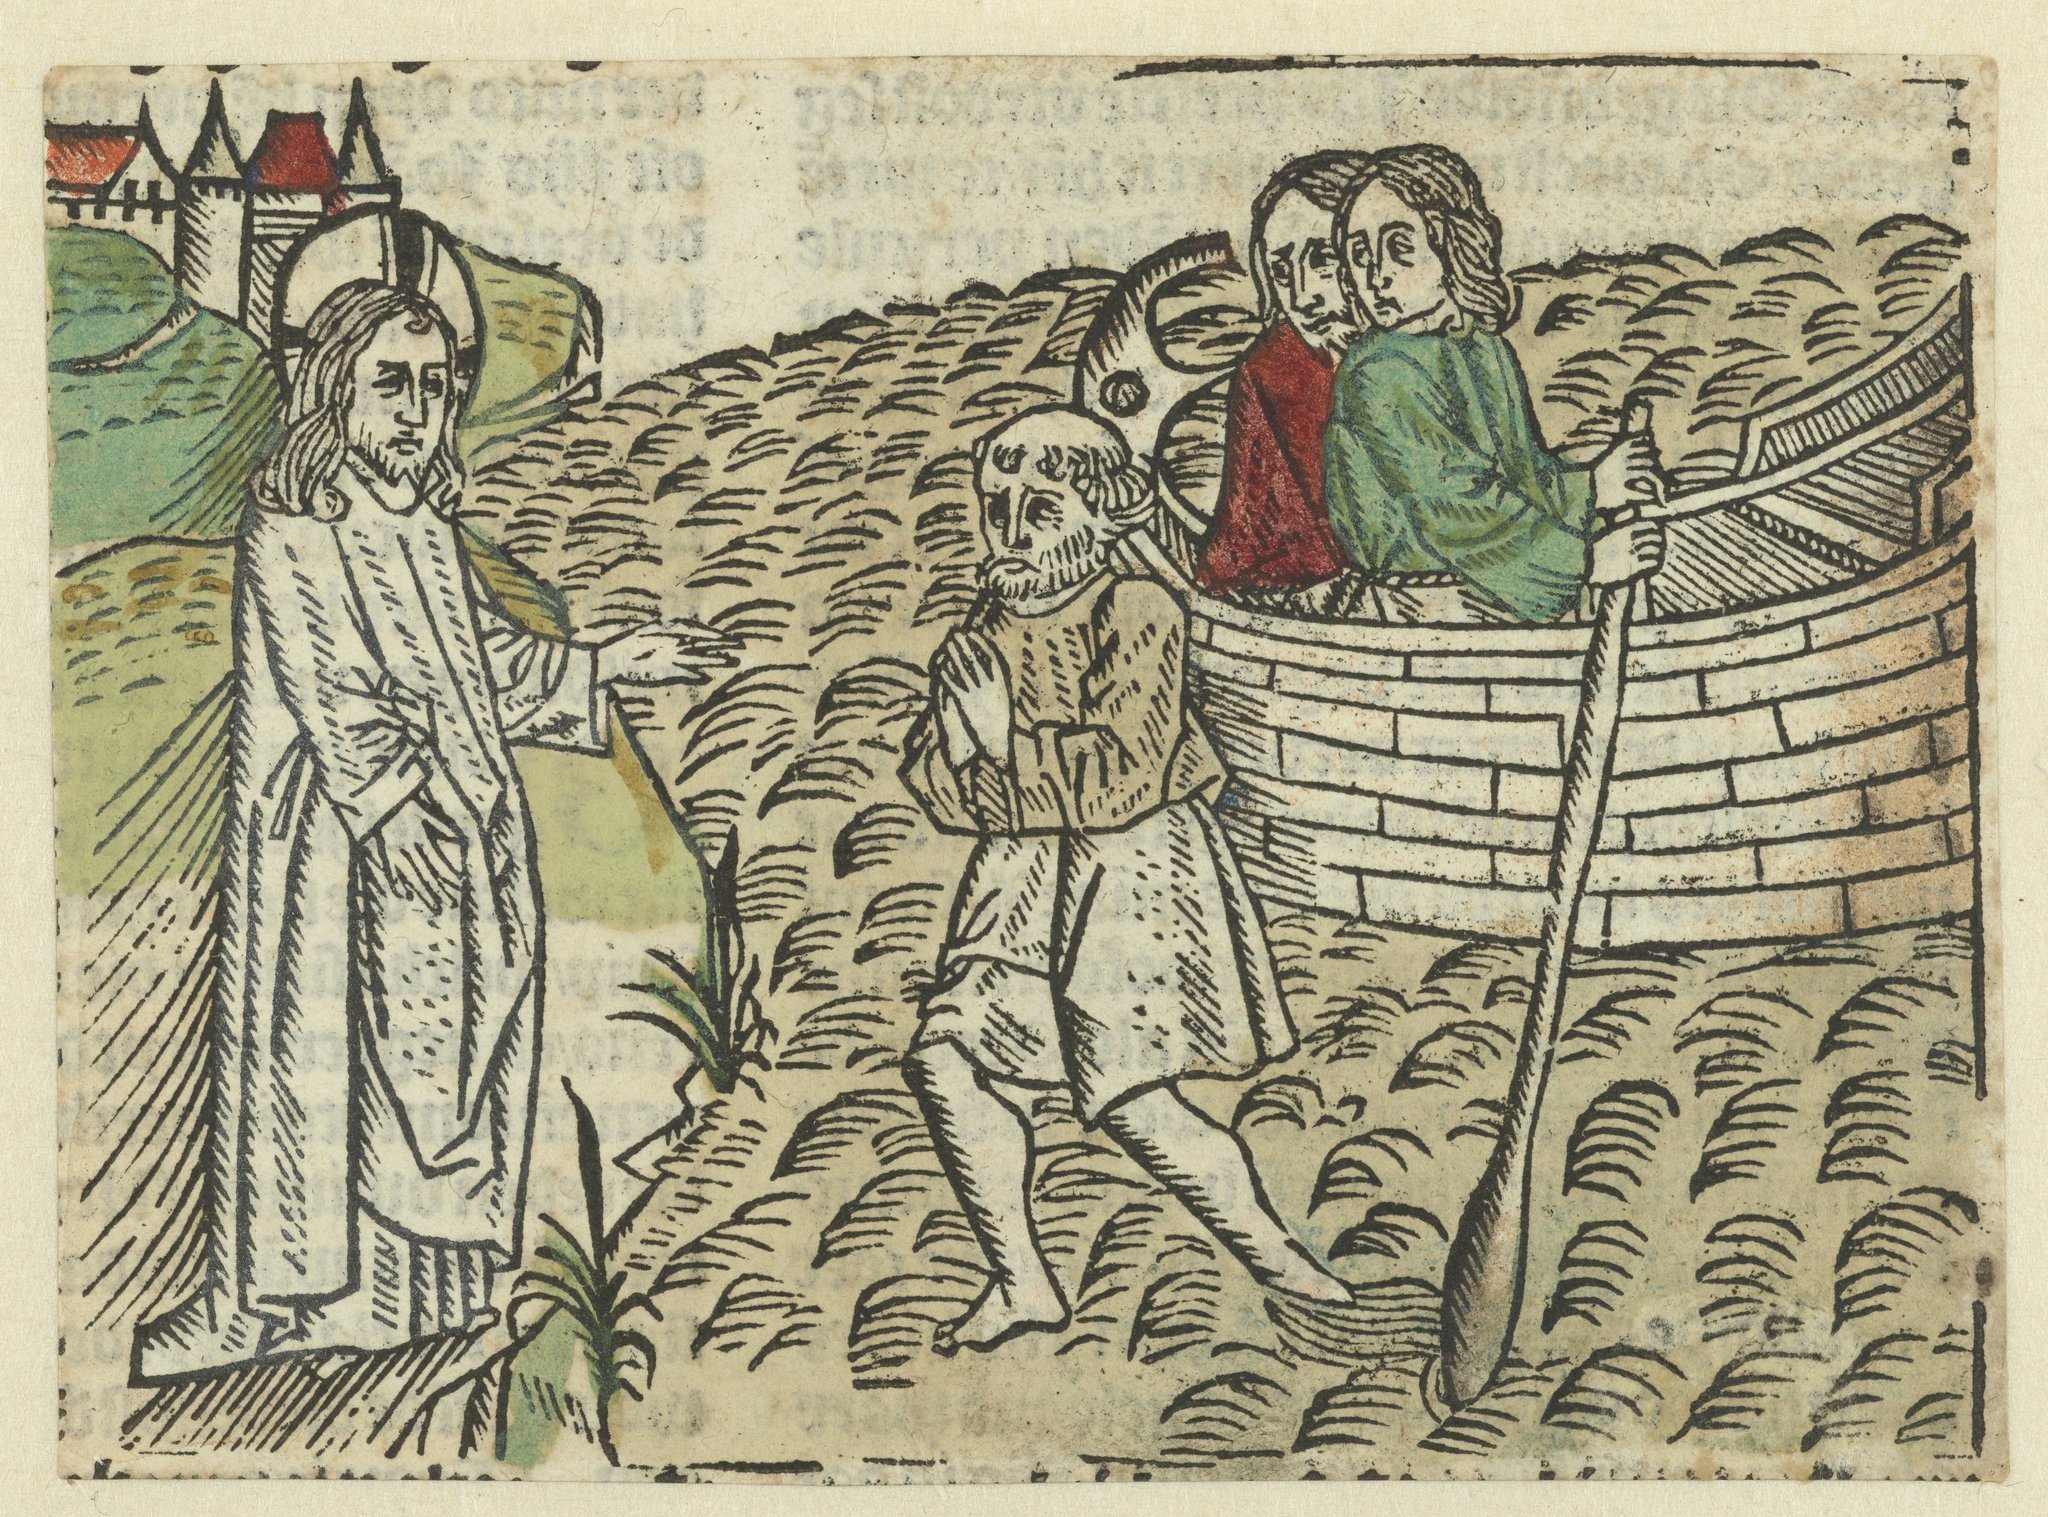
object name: book illustration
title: Petrus loopt op het water naar Christus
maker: the first antwerp woodcutter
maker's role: print maker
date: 1485-1491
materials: paper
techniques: hand coloring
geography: low countries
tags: peter walking on the water towards christ on the shore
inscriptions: collector's mark: Lugt 2228a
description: Eén van 46 houtsnedes uit Ludolphus de Saxonia "Tboeck vandan leven ons heeren Jesu Christi", een anonieme Nederlandse vertaling. Deze versie van het werk van Ludolphus bevat houtsneden van de Meester van Gouda (II), de Meester van Antwerpen (I) en de Meester van Haarlem. Botke, K. Boek van Ludolphus is voor het eerst uitgegeven in 1487 door Geeraert Leeu te Antwerpen. In 1488 uitgegeven door Claes Leeu te Antwerpen, in 1495 en 1499 en 1519 door Peter van Os te Zwolle en in 1510 door A. van Berghen te Antwerpen. Deze 46 houtsneden komen waarschijnlijk uit een uitgave van Peter van Os. Botke, K.